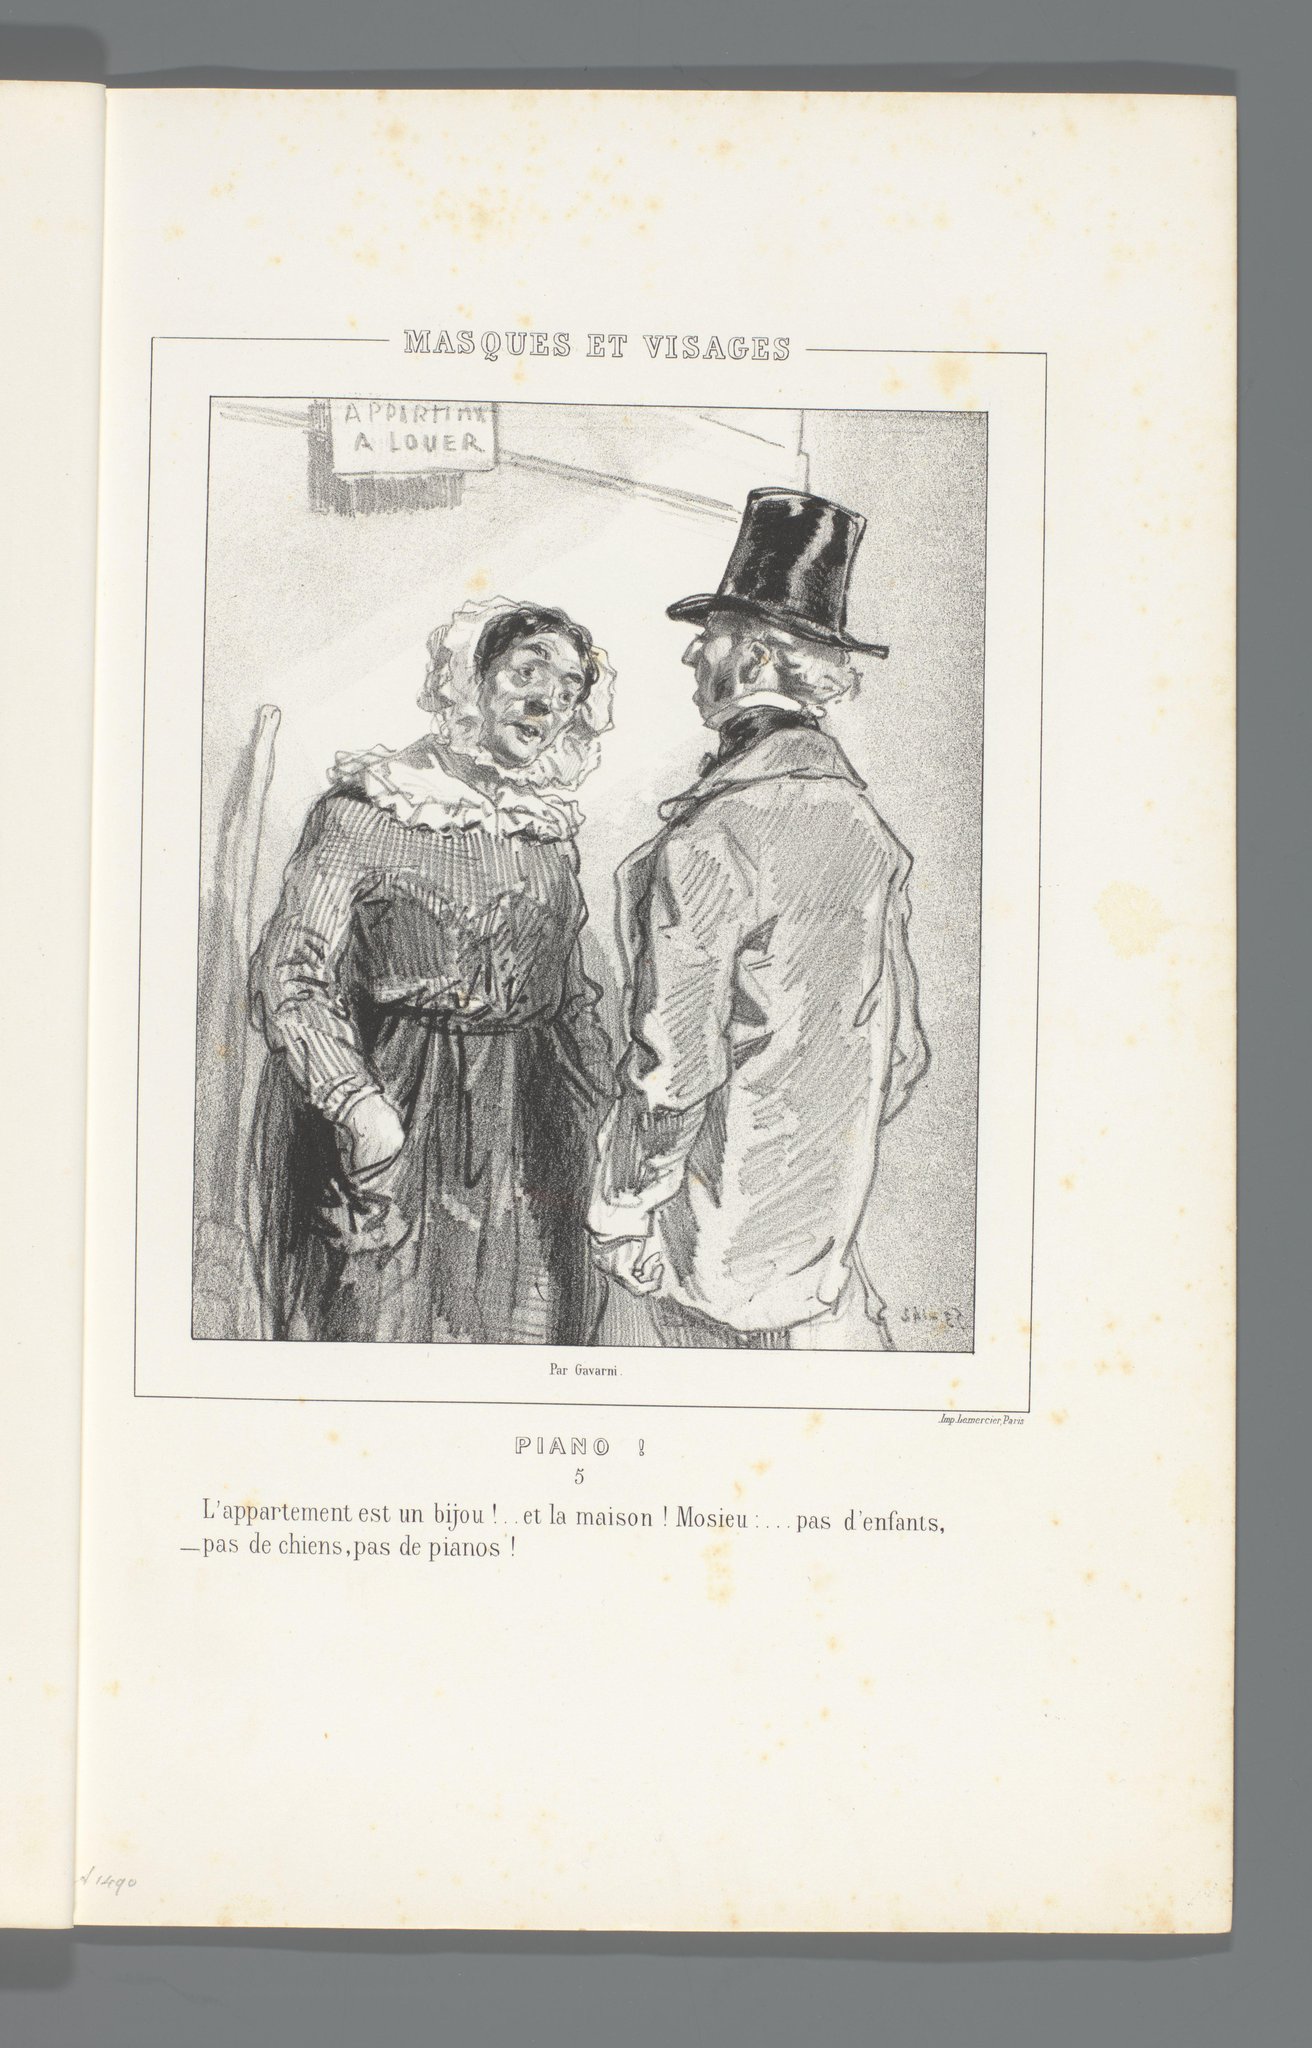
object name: album leaf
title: Masques et Visages. Piano!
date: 1853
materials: paper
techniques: lithograph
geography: paris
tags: house-guard, doorkeeper, janitor, flat-building, apartment house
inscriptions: collector's mark: Lugt 964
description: Deze prent maakt deel uit van een album. De huurder wordt verteld dat kinderen, honden of een piano niet toegestaan zijn in het appartement.